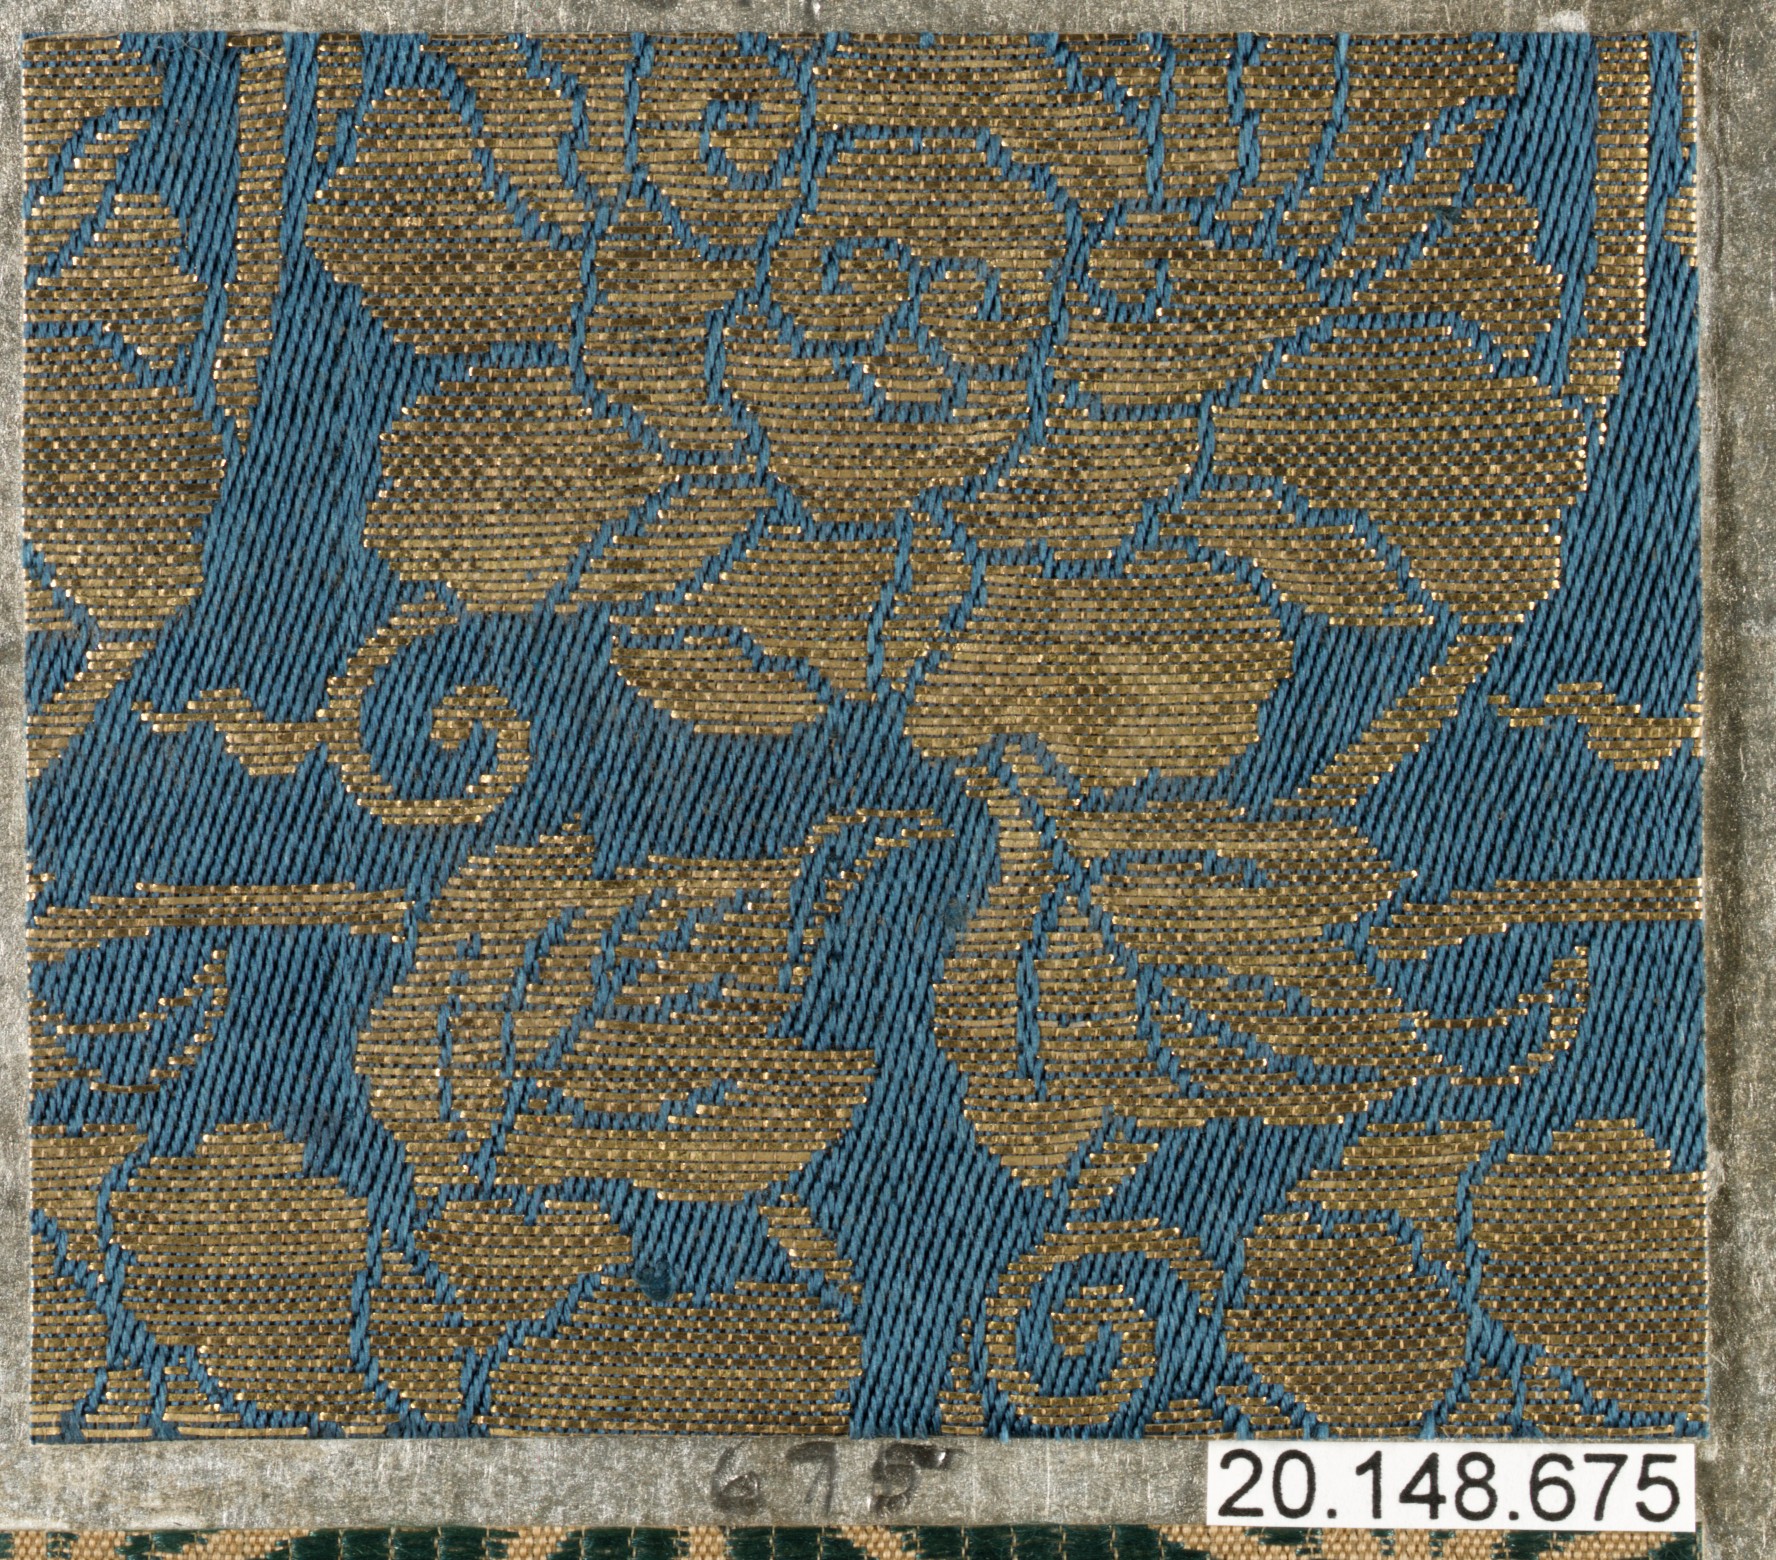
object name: piece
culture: japanese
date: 1701-1800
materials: silk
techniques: compound weave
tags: flowers,leaves